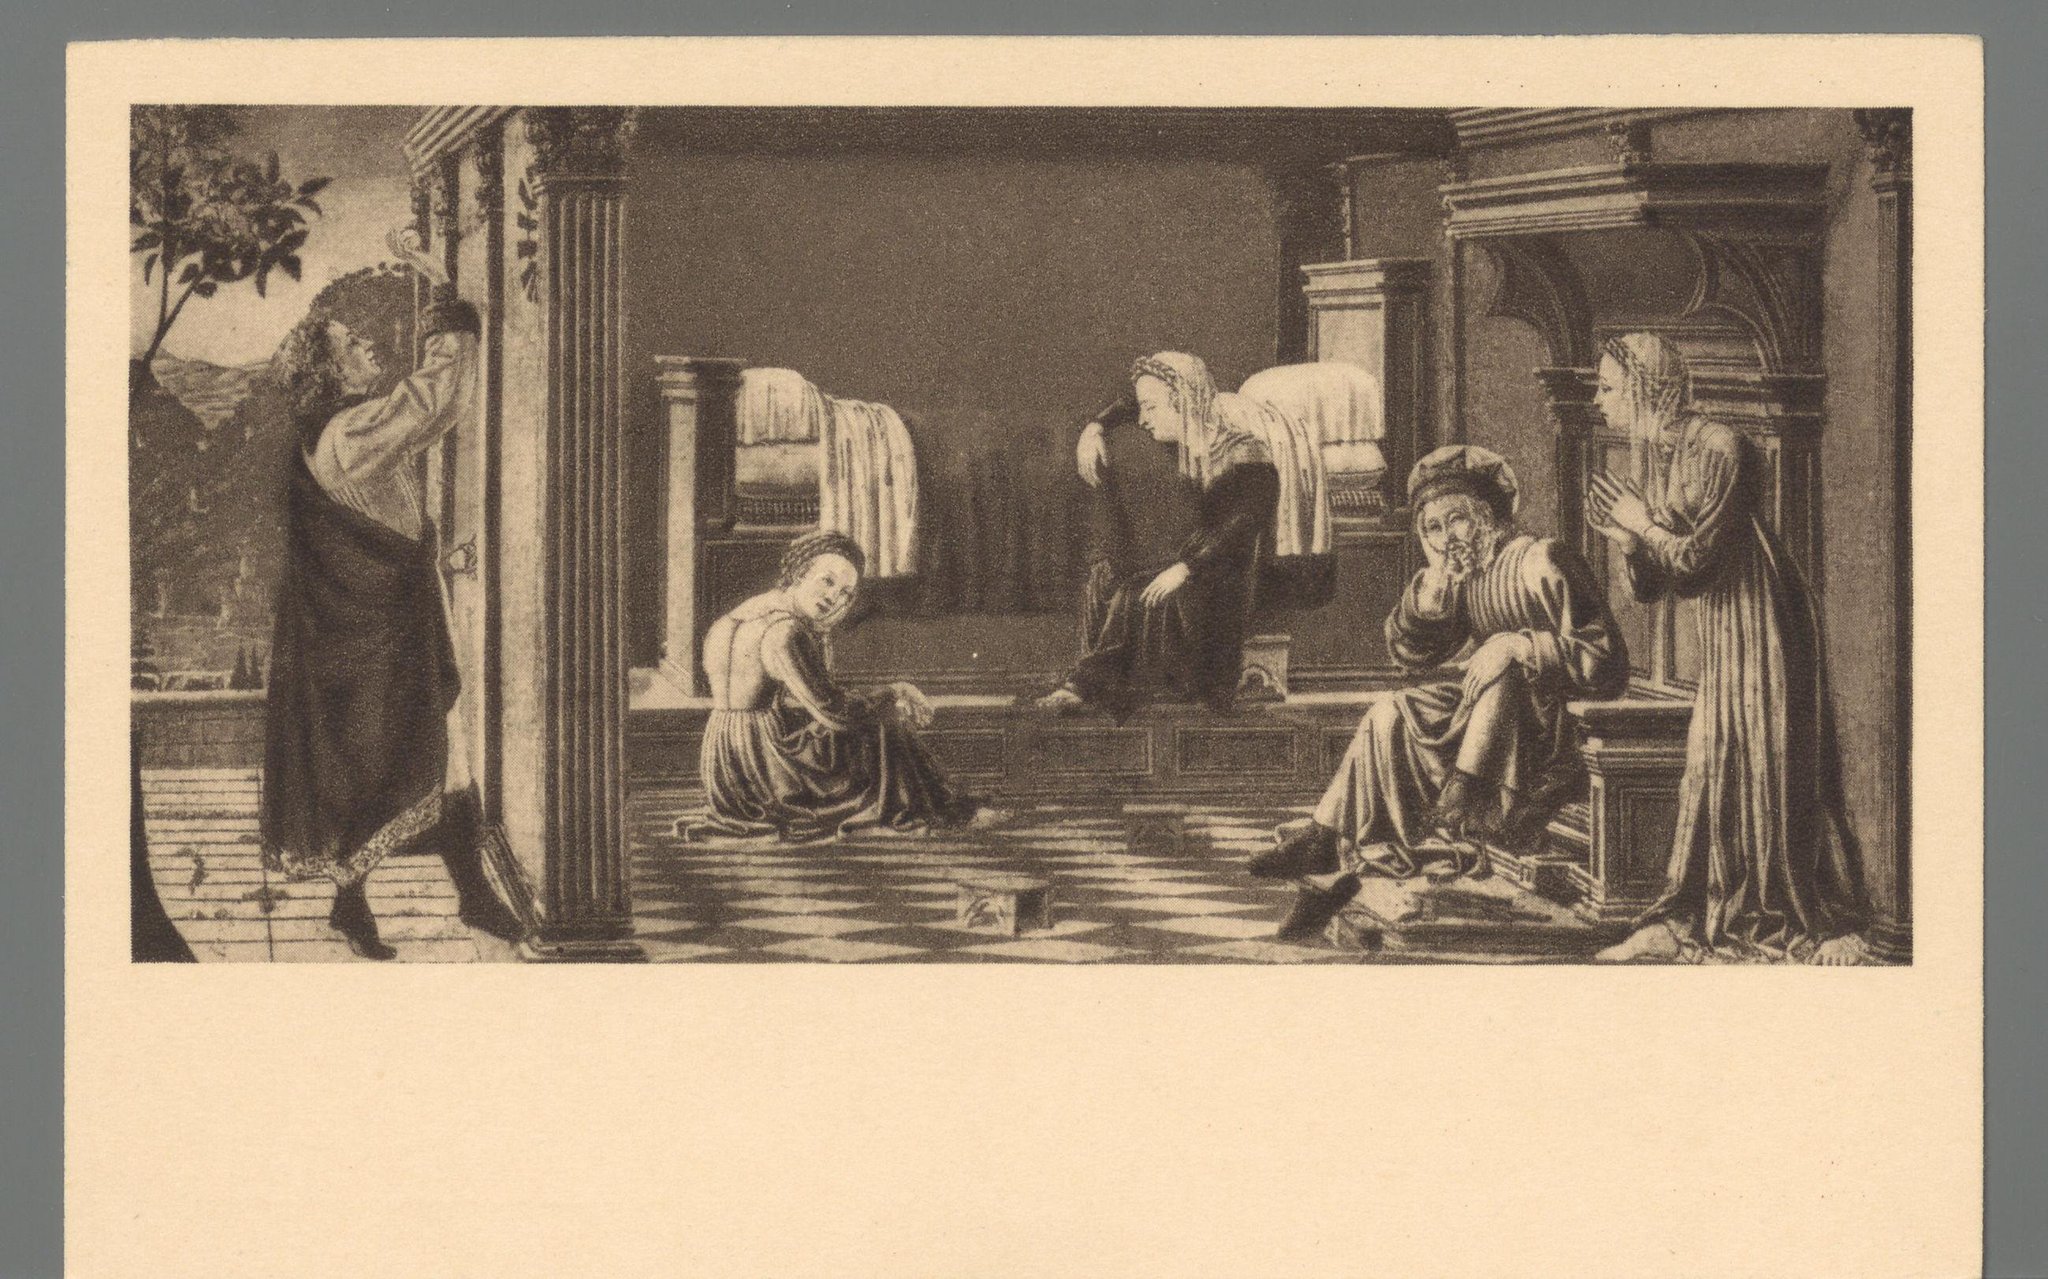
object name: photomechanical print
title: Francesco Pesellino (c. 1422-1457). De H. Nicolaas werpt drie gouden ballen als bruidsschat door het venster - Florence, Galleria Buonarroti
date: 1928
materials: cardboard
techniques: rotogravure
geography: milan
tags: permanent exhibition, museum, picture, painting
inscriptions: collector's mark: ‘AFE v S’